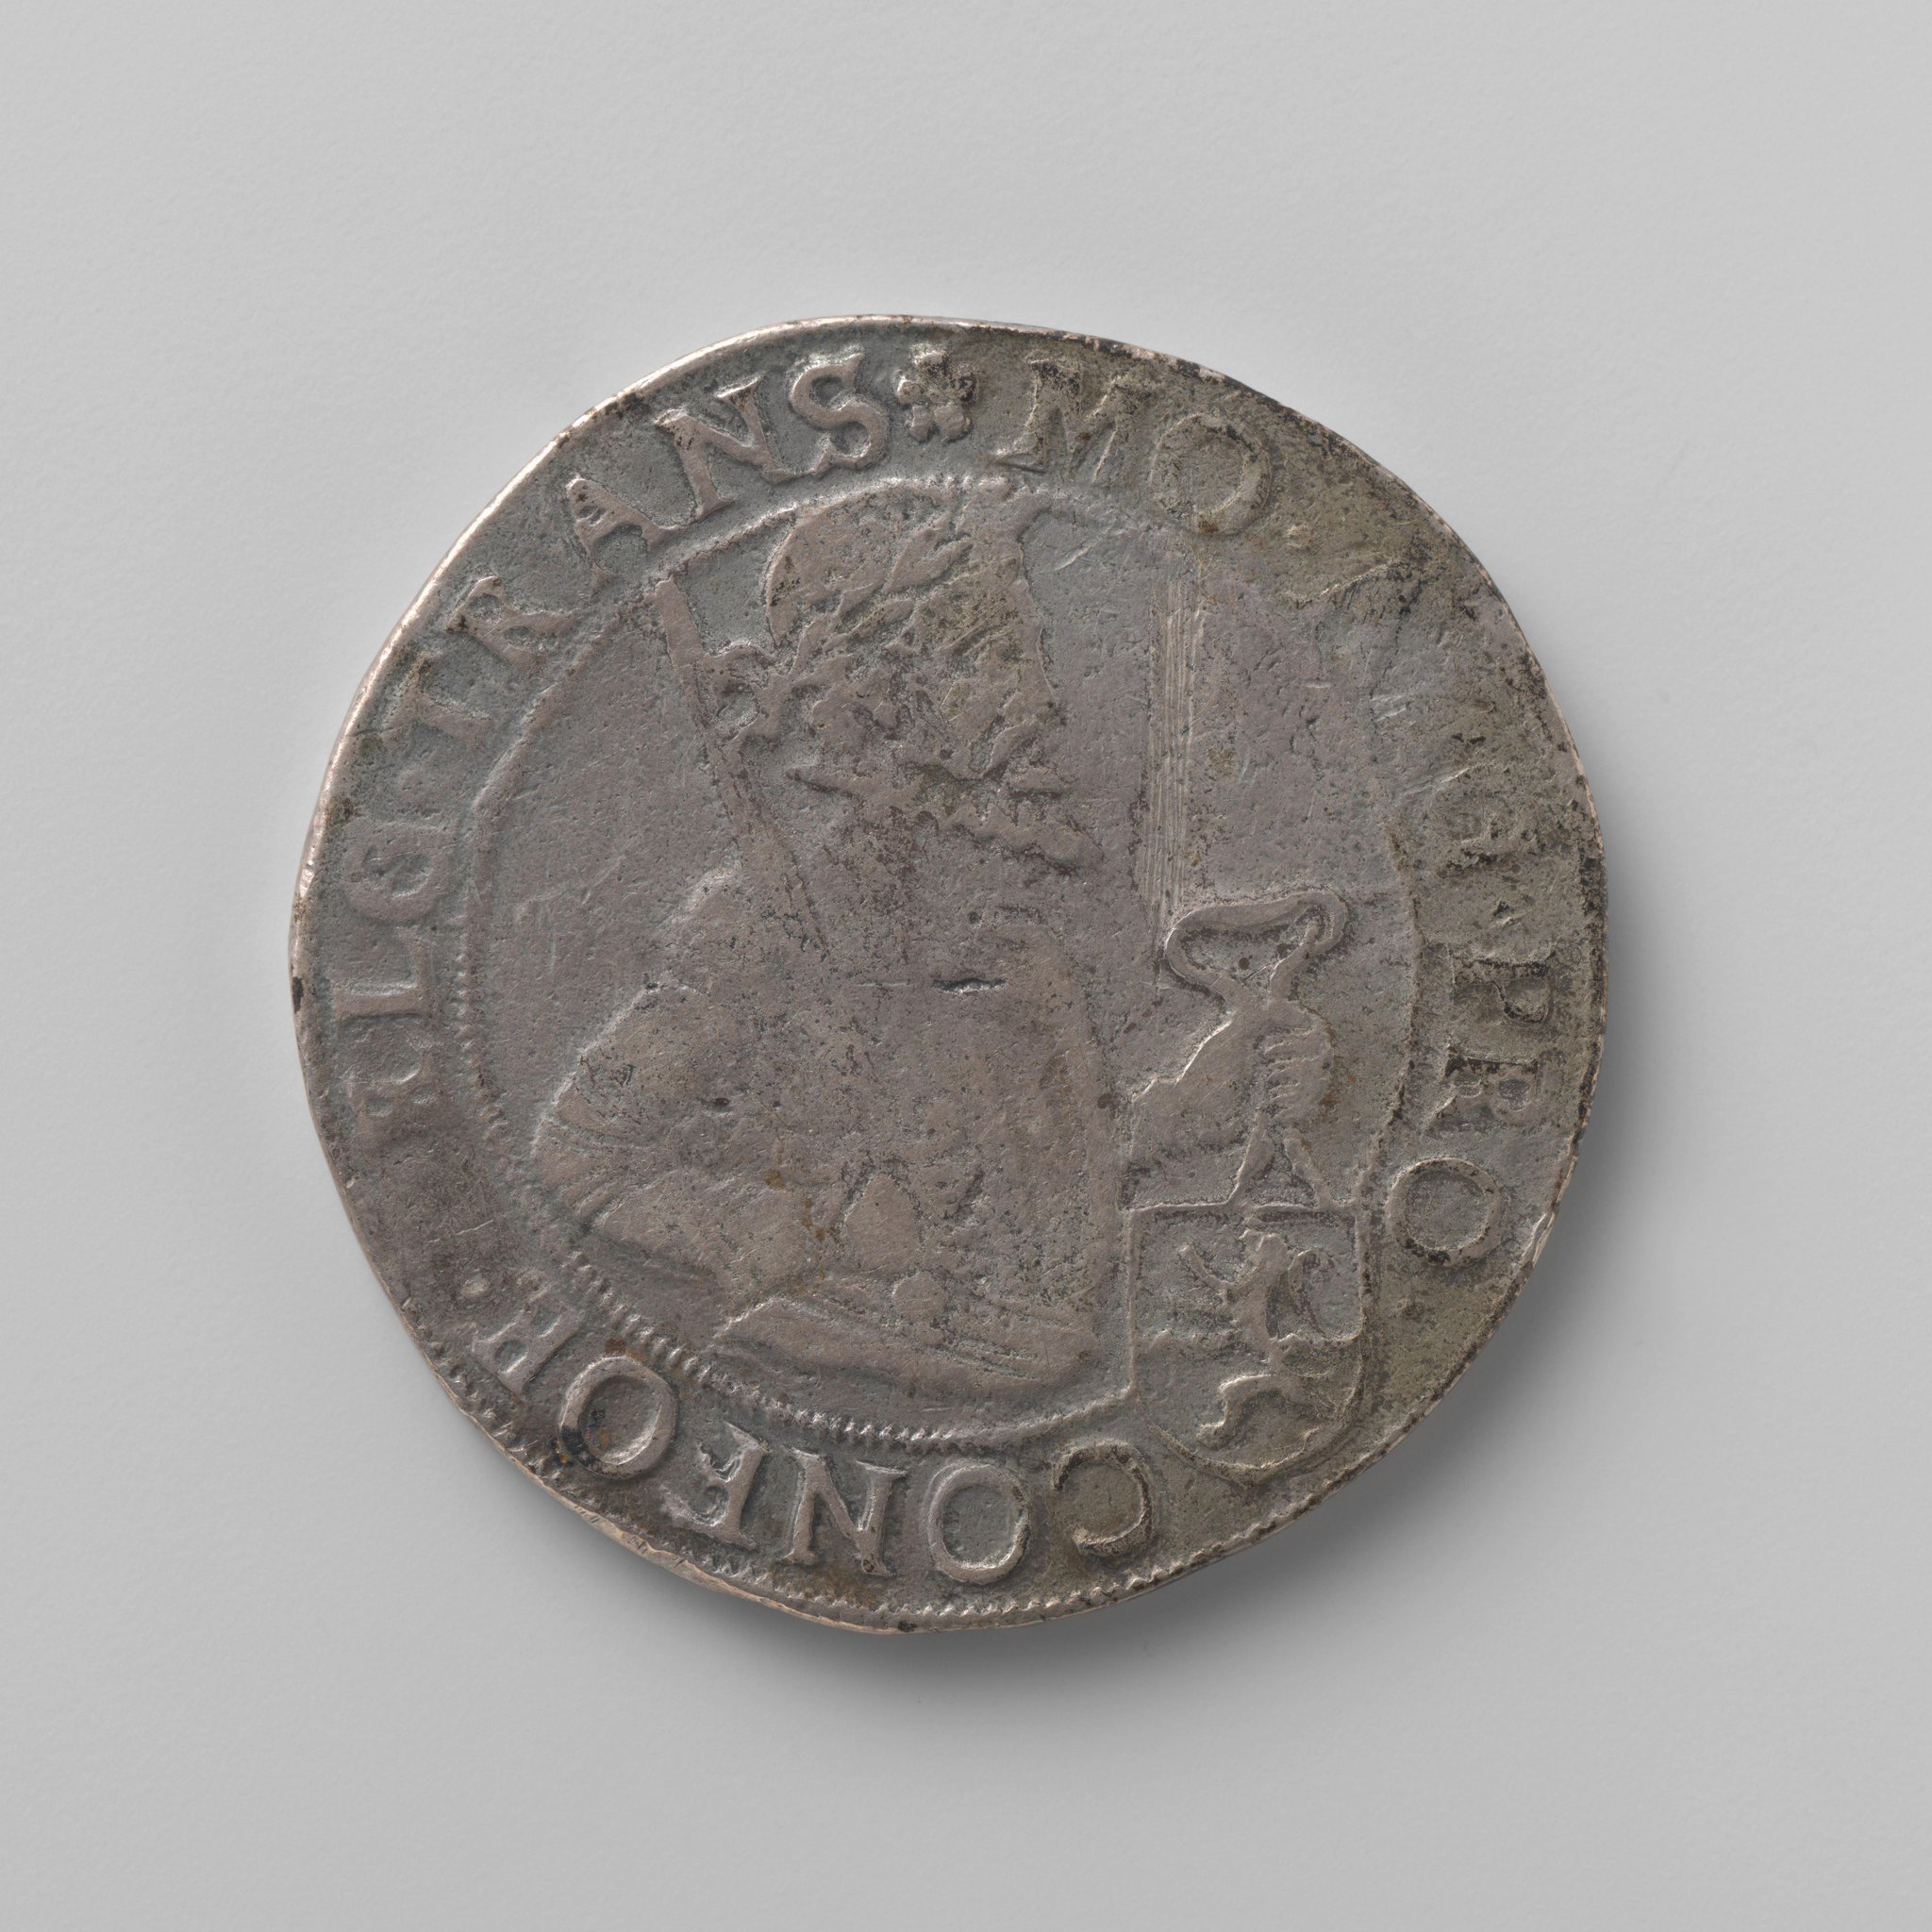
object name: coin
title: Overijssel, nederlandse rijksdaalder, 1620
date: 1620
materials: silver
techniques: striking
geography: kampen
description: Zilveren munt. Voorzijde: tussen jaartal gekroond generaliteitswapenschild. Keerzijde: gelauwerd en geharnast borstbeeld naar rechts, met in rechterhand zwaaard en in linkerhand provinciaal wapenschild aan lint.